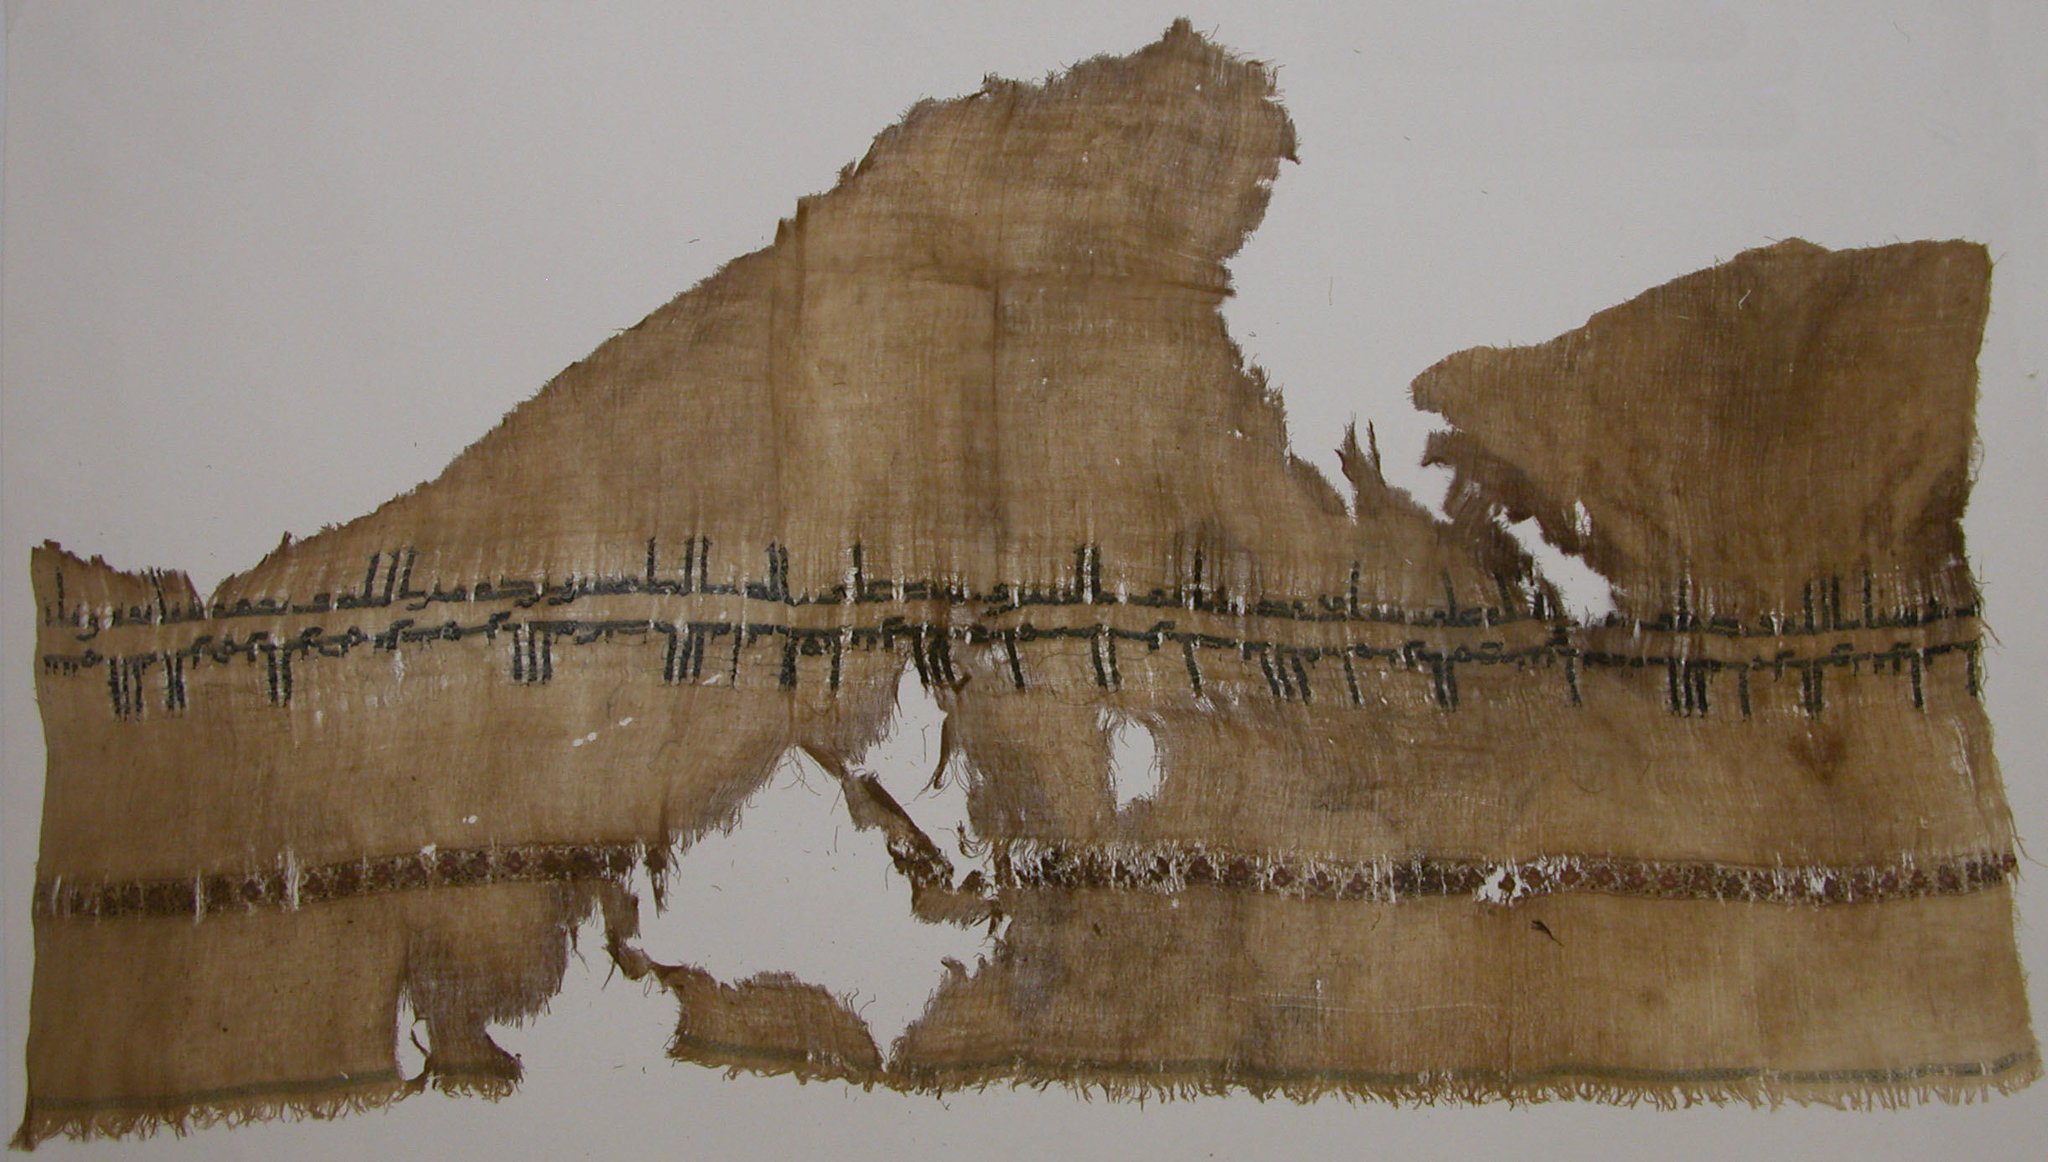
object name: textile fragment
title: Textile Fragment with Inscription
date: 934-940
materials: linen, silk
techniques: weave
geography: egypt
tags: arabic